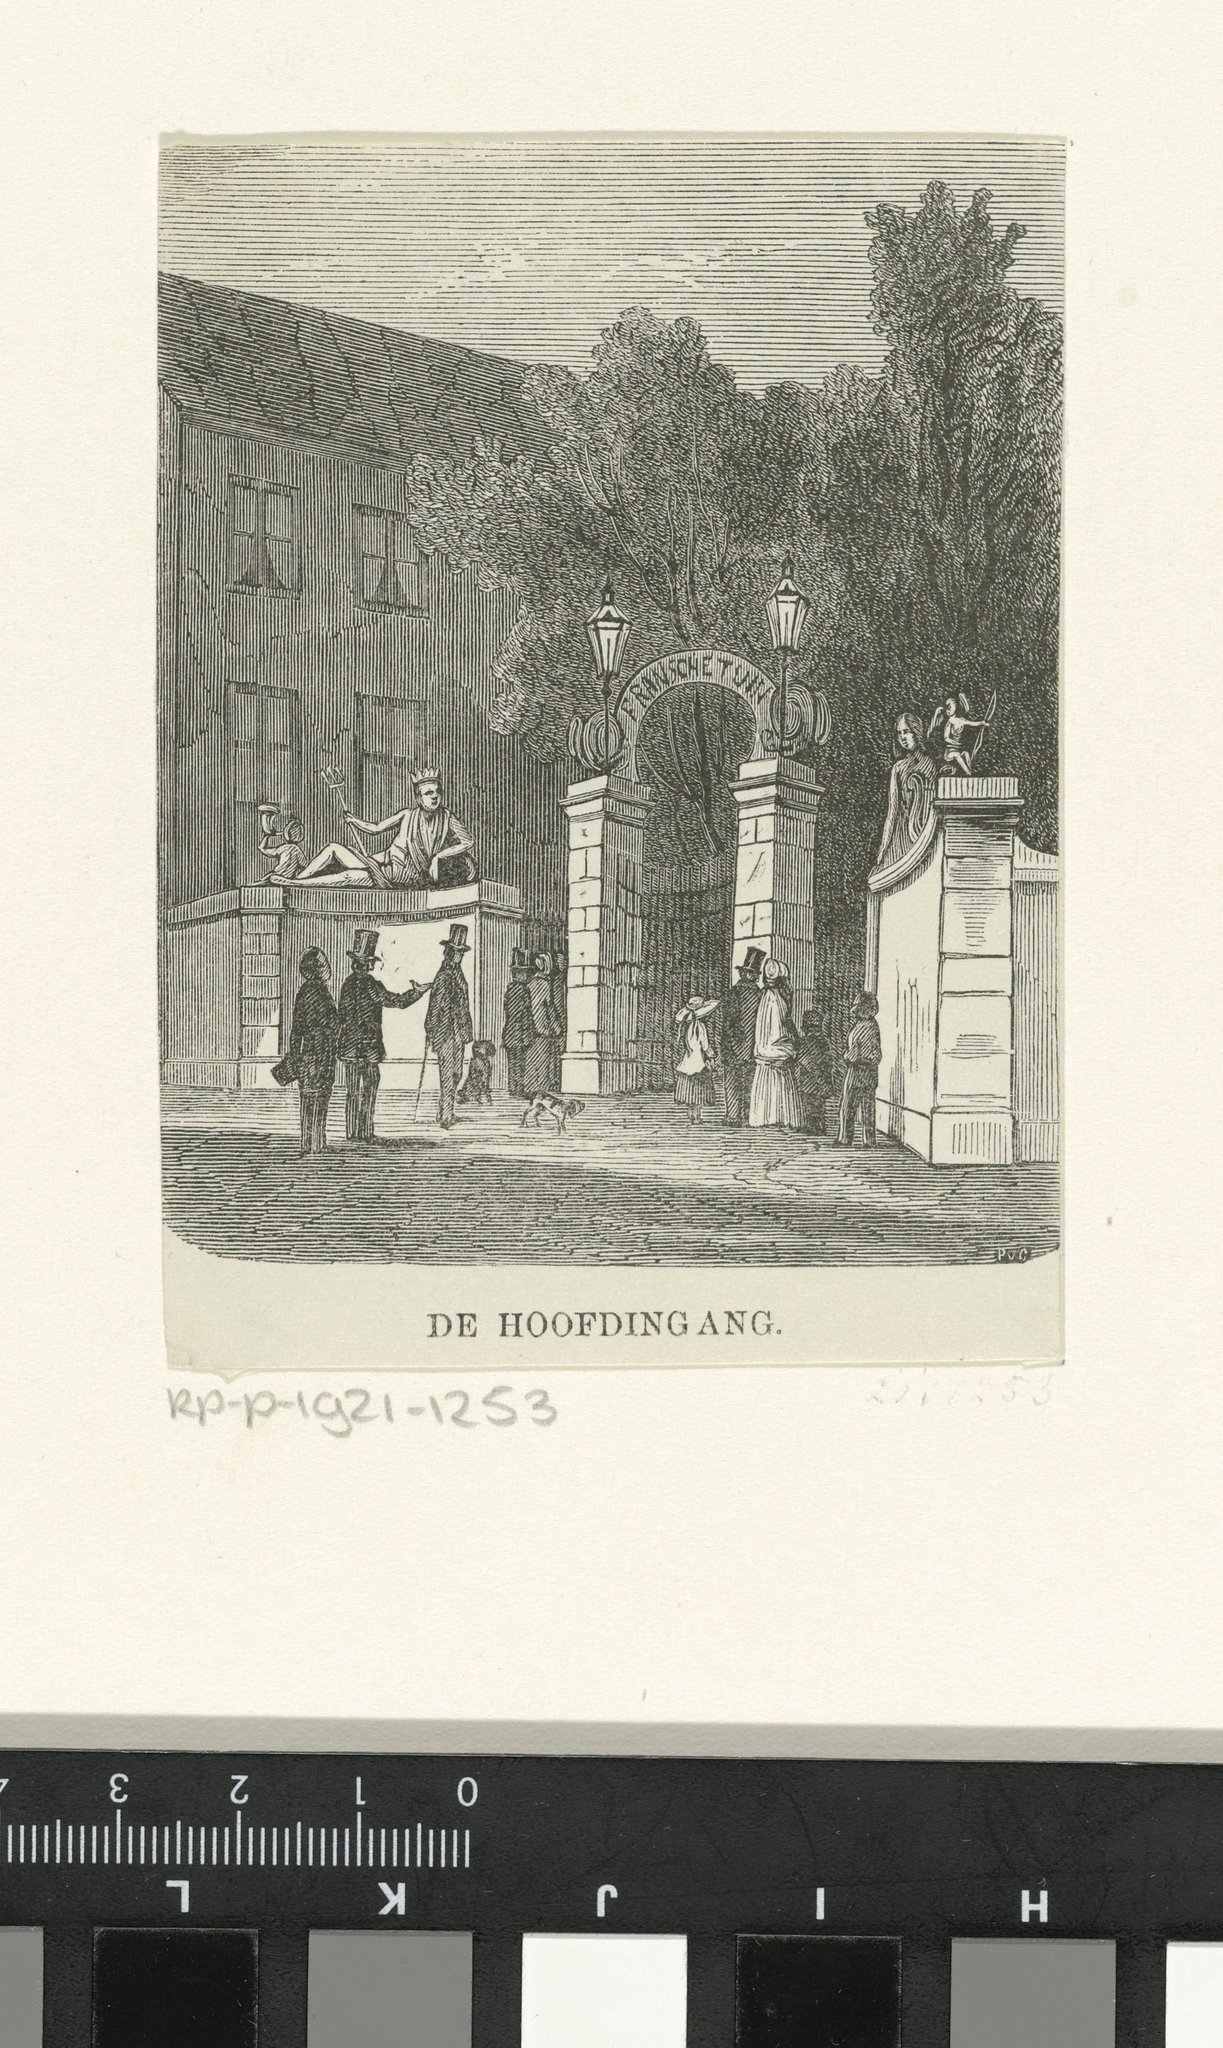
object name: print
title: Hoofdingang van de Franse tuin in het Park aan de Plantage Parklaan te Amsterdam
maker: popko van groningen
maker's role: print maker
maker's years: 1822-1888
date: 1832-1888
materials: paper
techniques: letterpress printing, engraving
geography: netherlands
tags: french or architectonic garden; formal garden